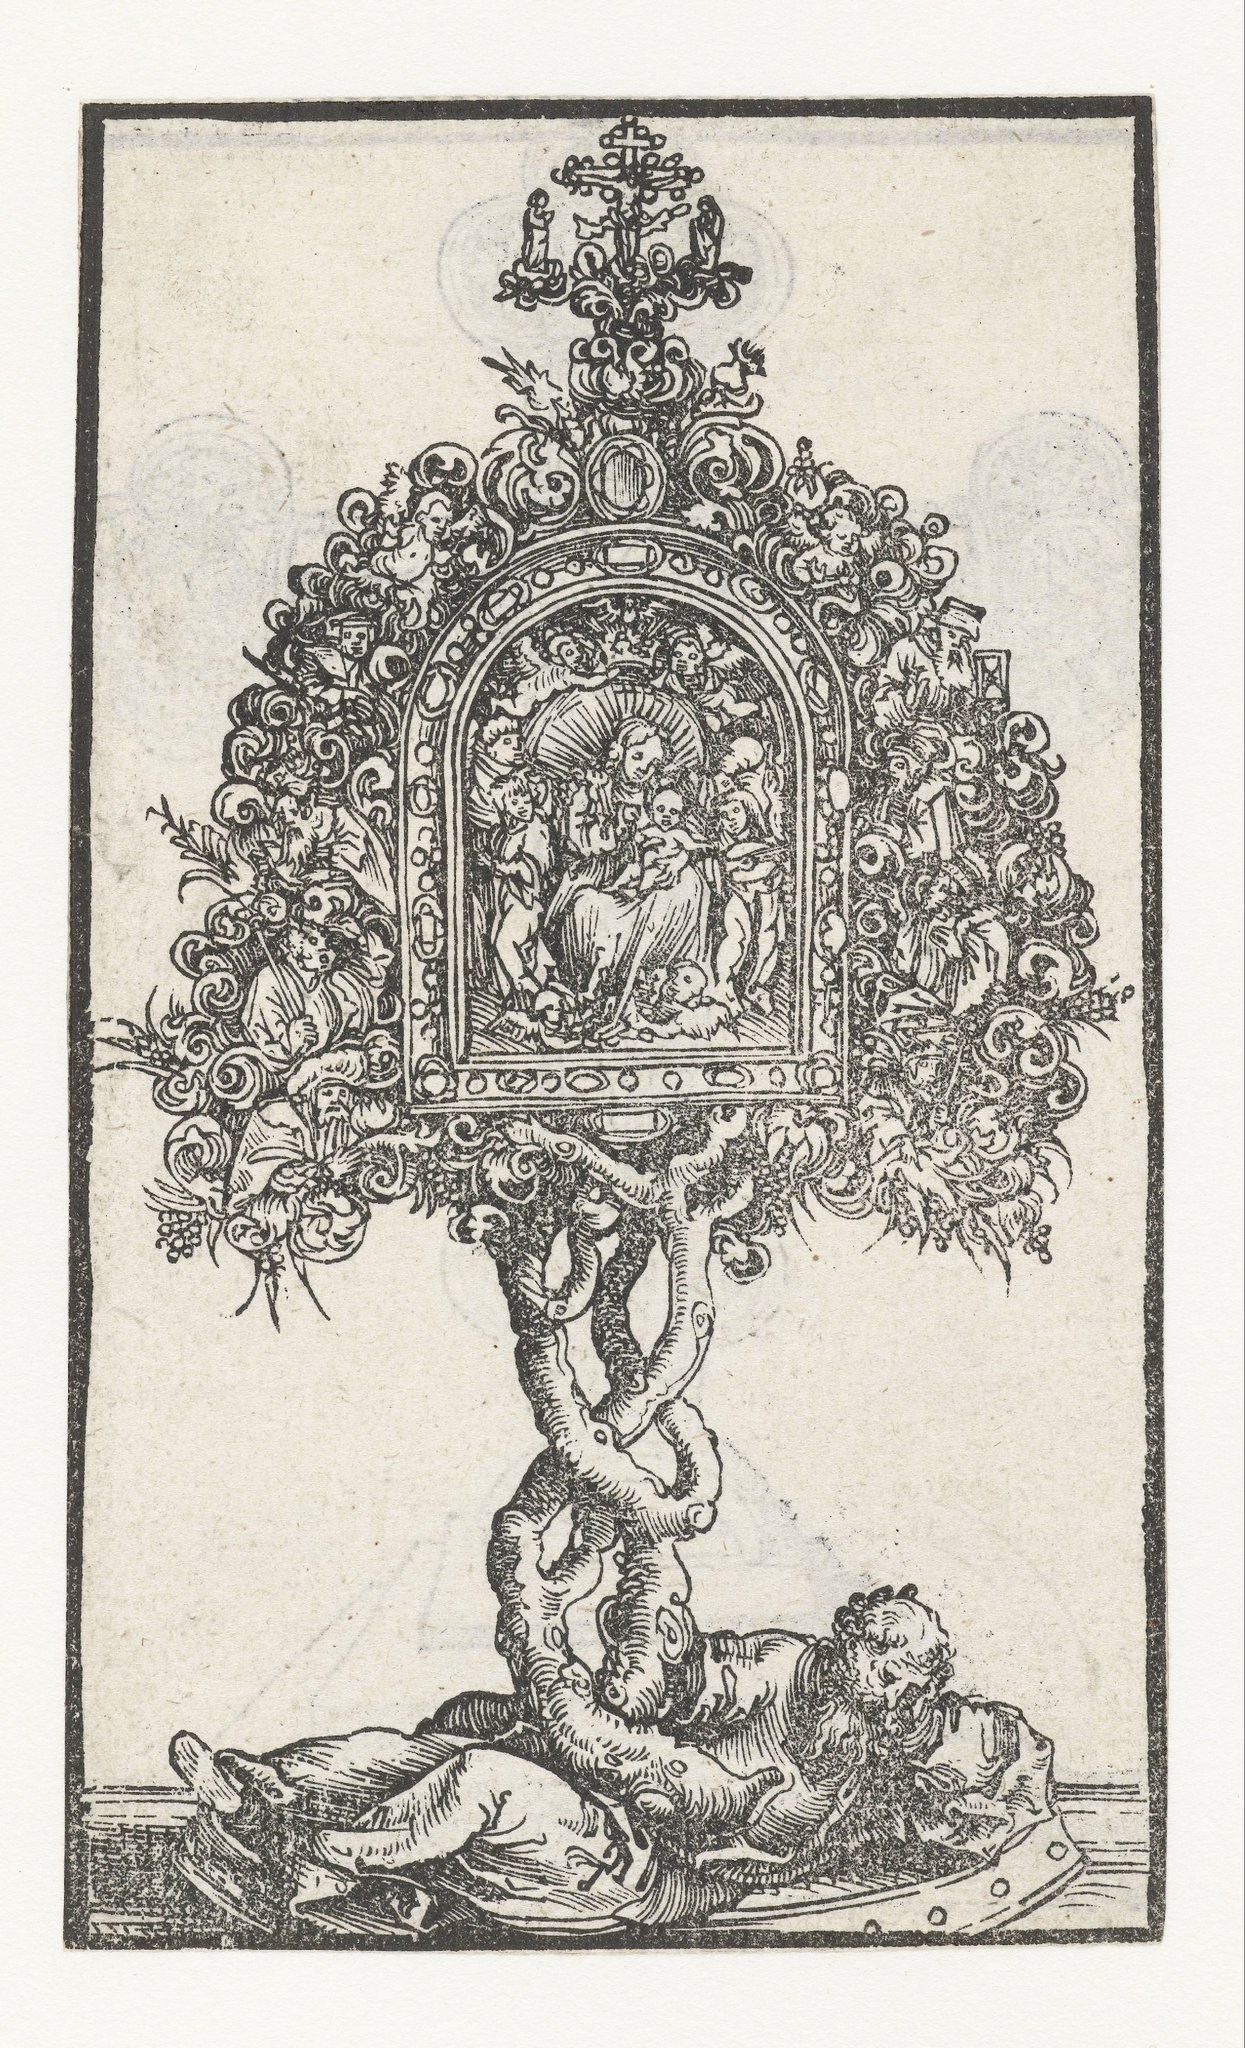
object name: book illustration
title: Reliekhouder met de boom van Jesse en Maria met kind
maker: lucas cranach (i)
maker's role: draughtsman, print maker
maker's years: 1472-1553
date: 1509-1549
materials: paper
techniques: woodcut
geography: wittenberg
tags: tree of jesse: genealogical tree showing christ's ancestors, sprouting from jesse's loins, relics (and reliquaries)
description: De houtblokken werden in 1509 voor het eerst gebruikt in: Dye zaigung des hochlobwirdigen hailigthums der Stiftkirchen allerhailigen zu wittenburg, Wittenberg, Symphorian Reinhart. Daarna volgden verschillende uitgaven van de Hortulus Animae (uitgever Georg Rhau) waarin de blokken opnieuw gebruikt werden.